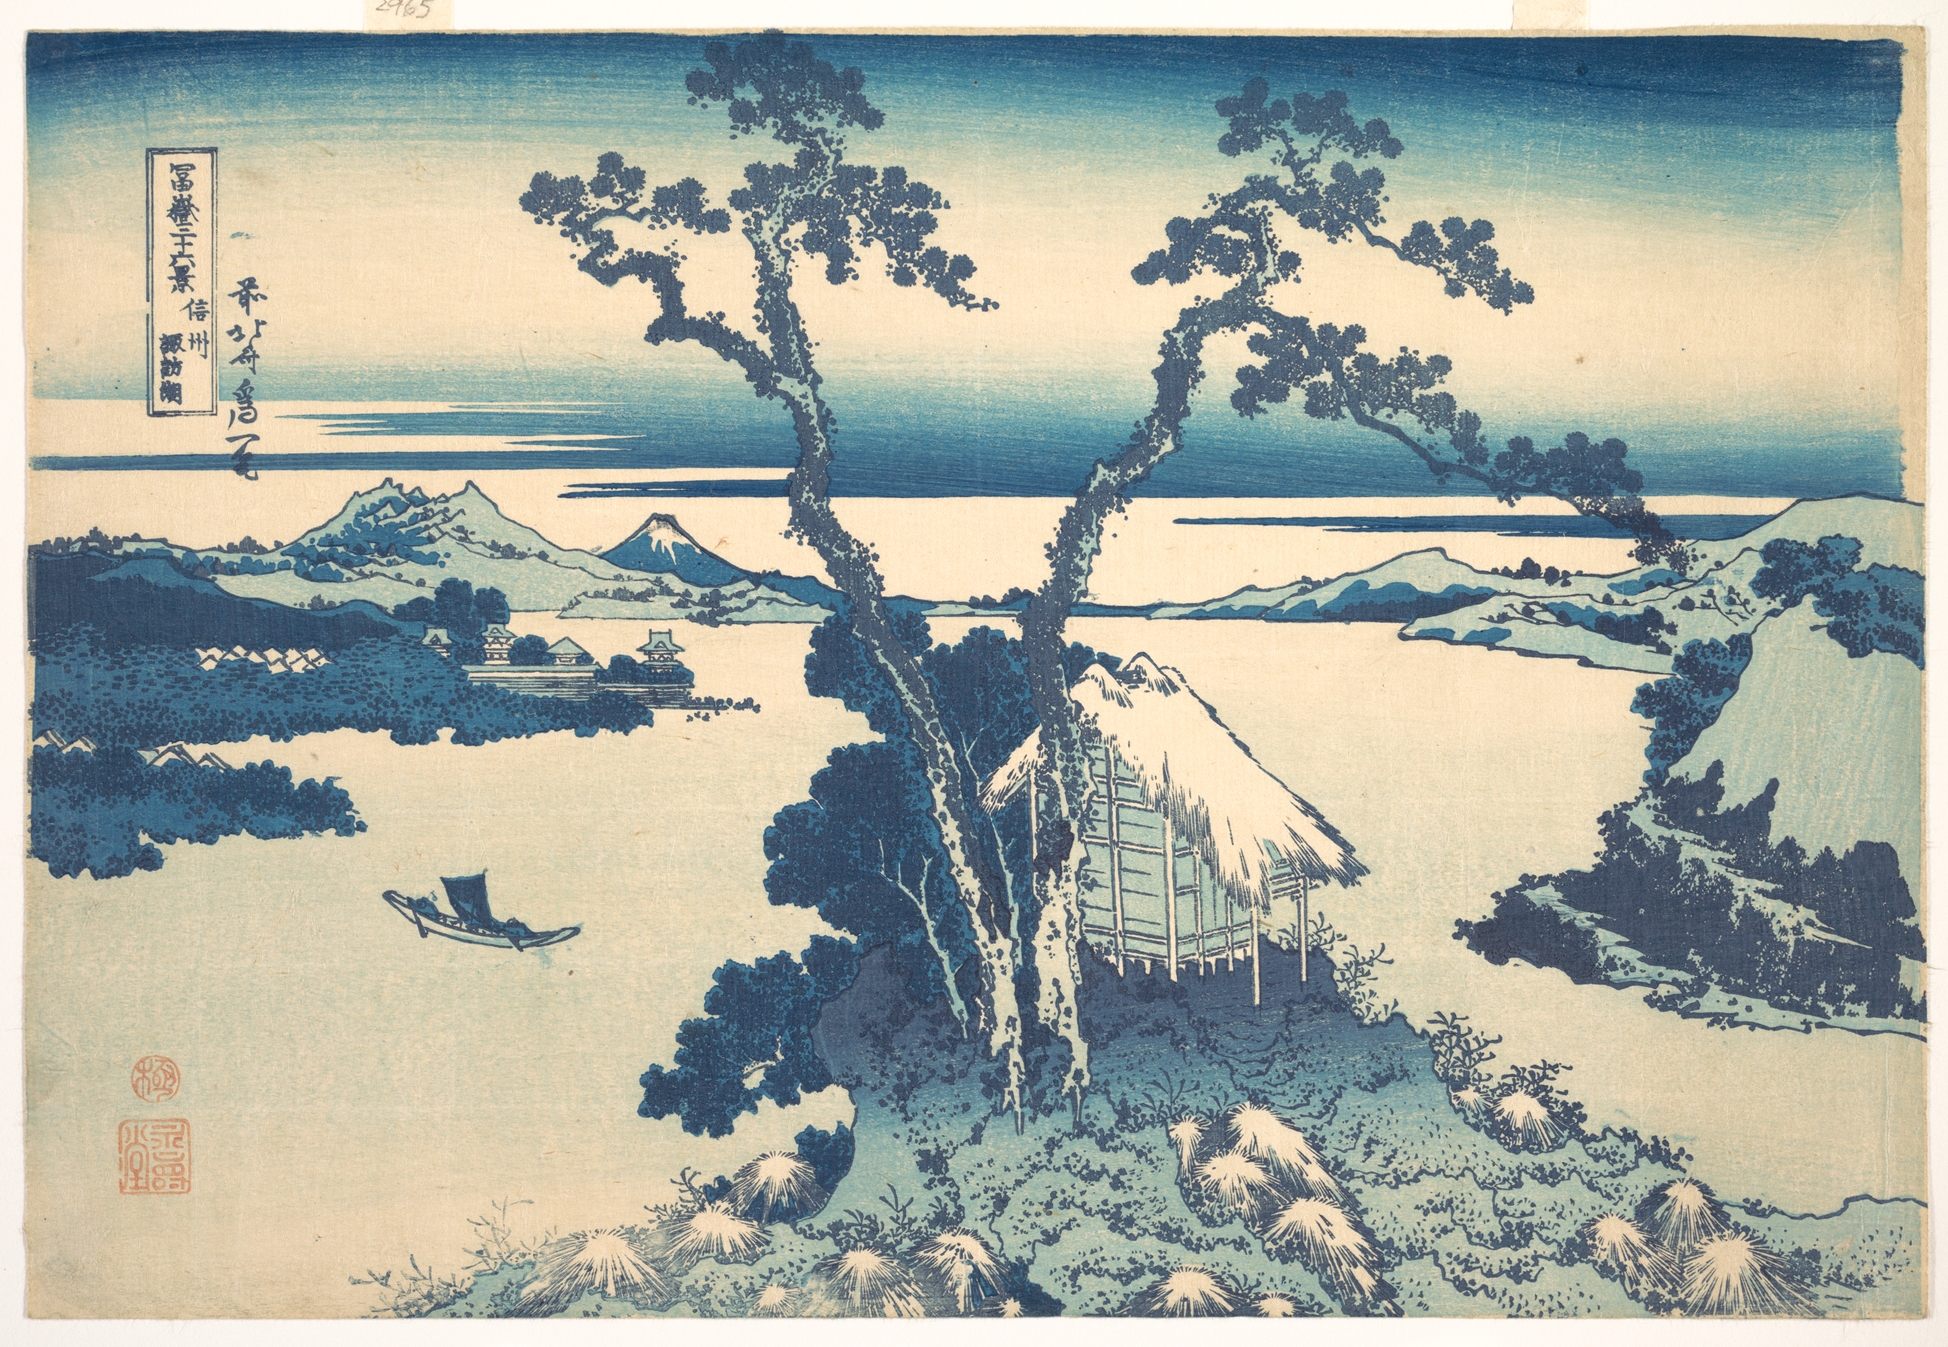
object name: woodblock print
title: Lake Suwa in Shinano Province (Shinshū Suwako), from the series Thirty-six Views of Mount Fuji (Fugaku sanjūrokkei)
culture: japanese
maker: katsushika hokusai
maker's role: artist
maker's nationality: japanese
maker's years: 1760-1849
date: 1830-1832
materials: ink, paper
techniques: woodblock print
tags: houses,lakes,landscapes,trees,boats